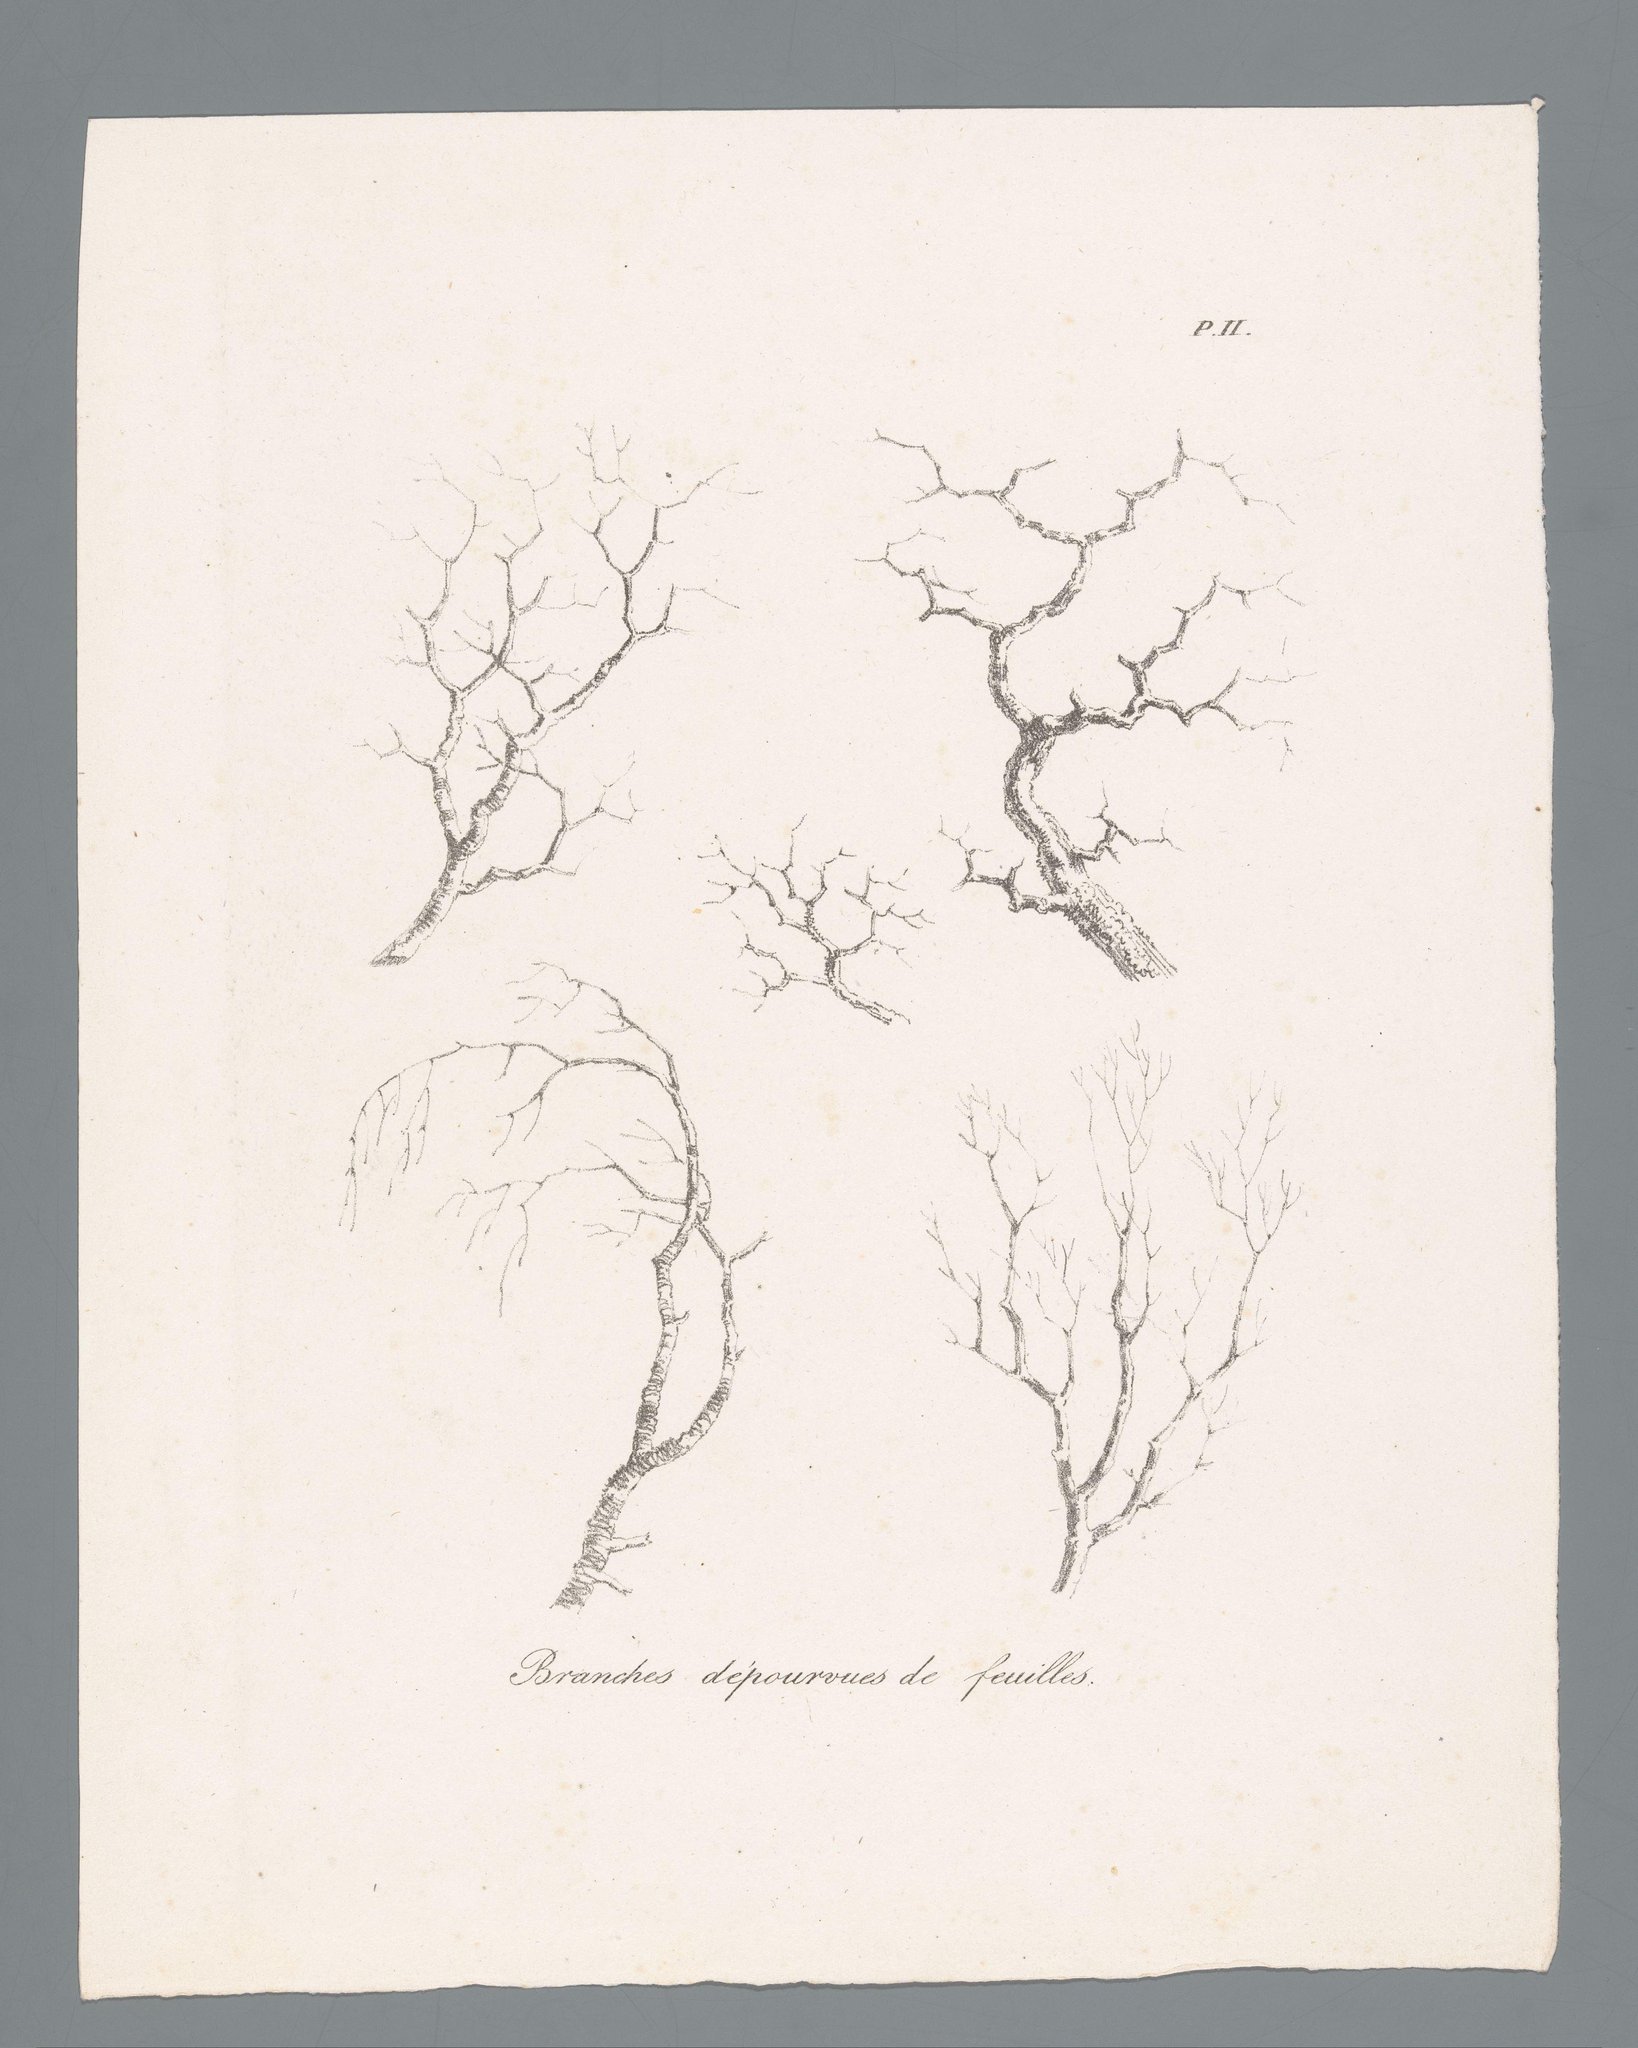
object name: print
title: Études d'arbres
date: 1820-1833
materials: paper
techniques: lithograph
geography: paris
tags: trees (+ branch, stick)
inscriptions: collector's mark: Lugt 2228